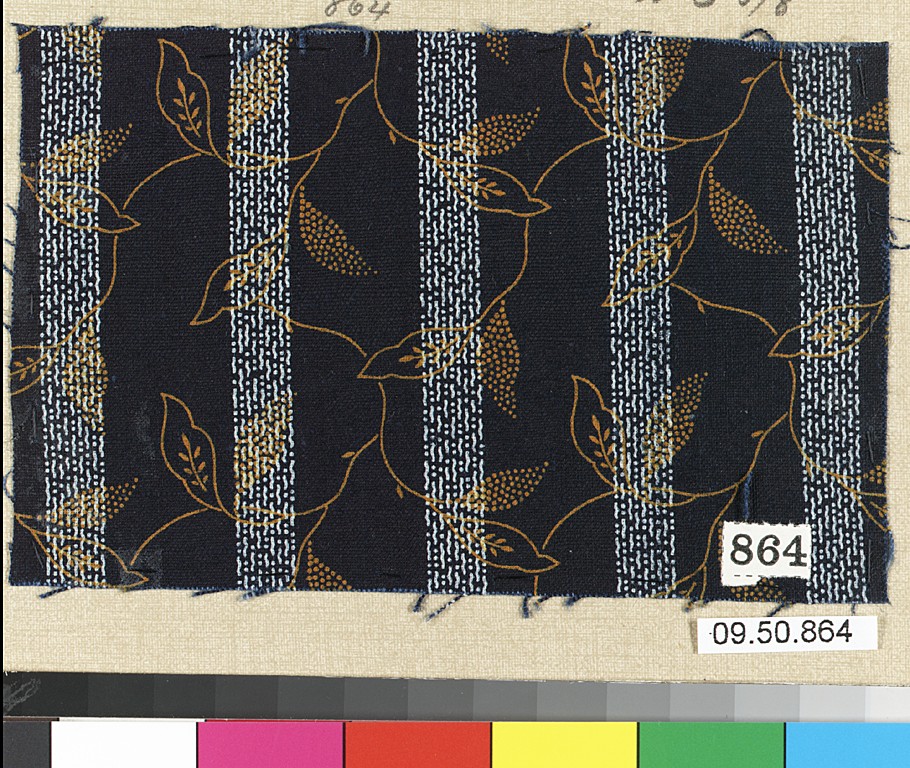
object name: piece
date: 1801-1900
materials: cotton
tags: leaves